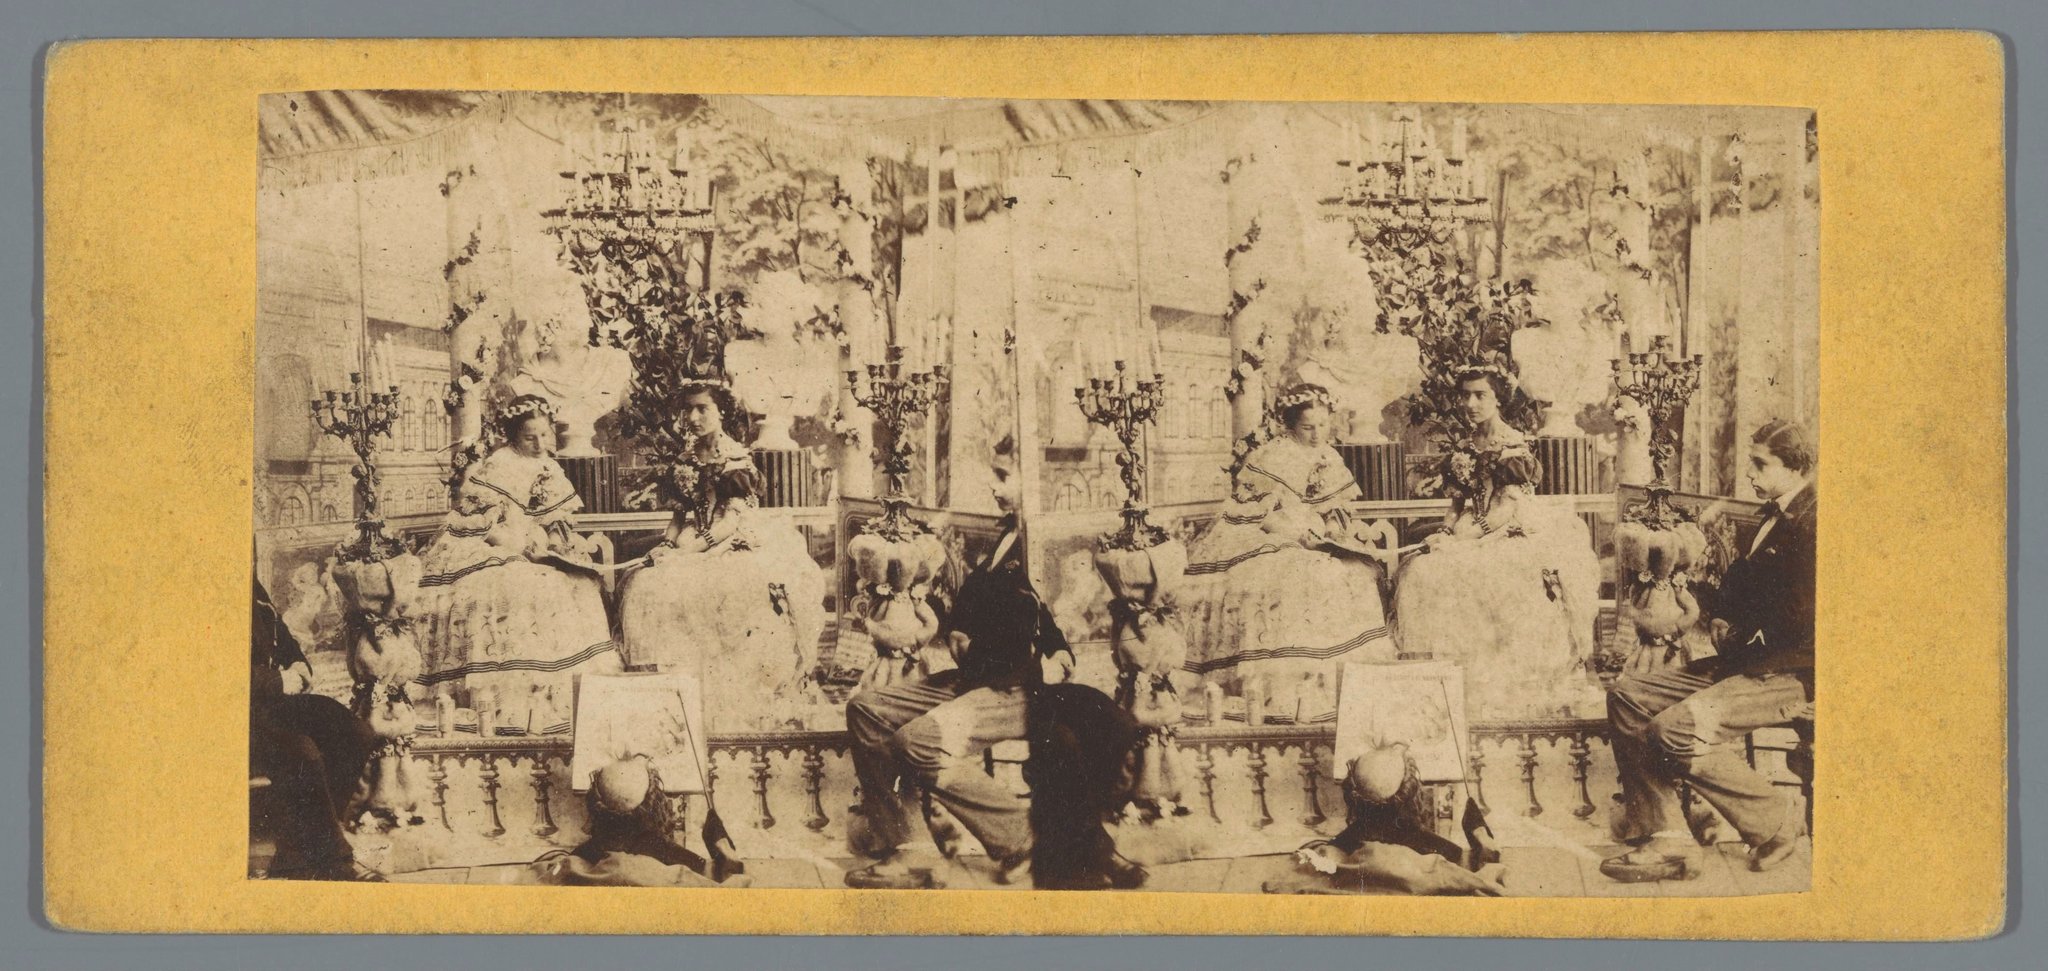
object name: stereograph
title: Twee vrouwen met op de voorgrond een dirigent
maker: Anonymous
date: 1850-1880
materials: cardboard, photographic support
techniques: albumen print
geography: europe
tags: vocal music, singing, conductor ~ music, europe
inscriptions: number: ‘25’